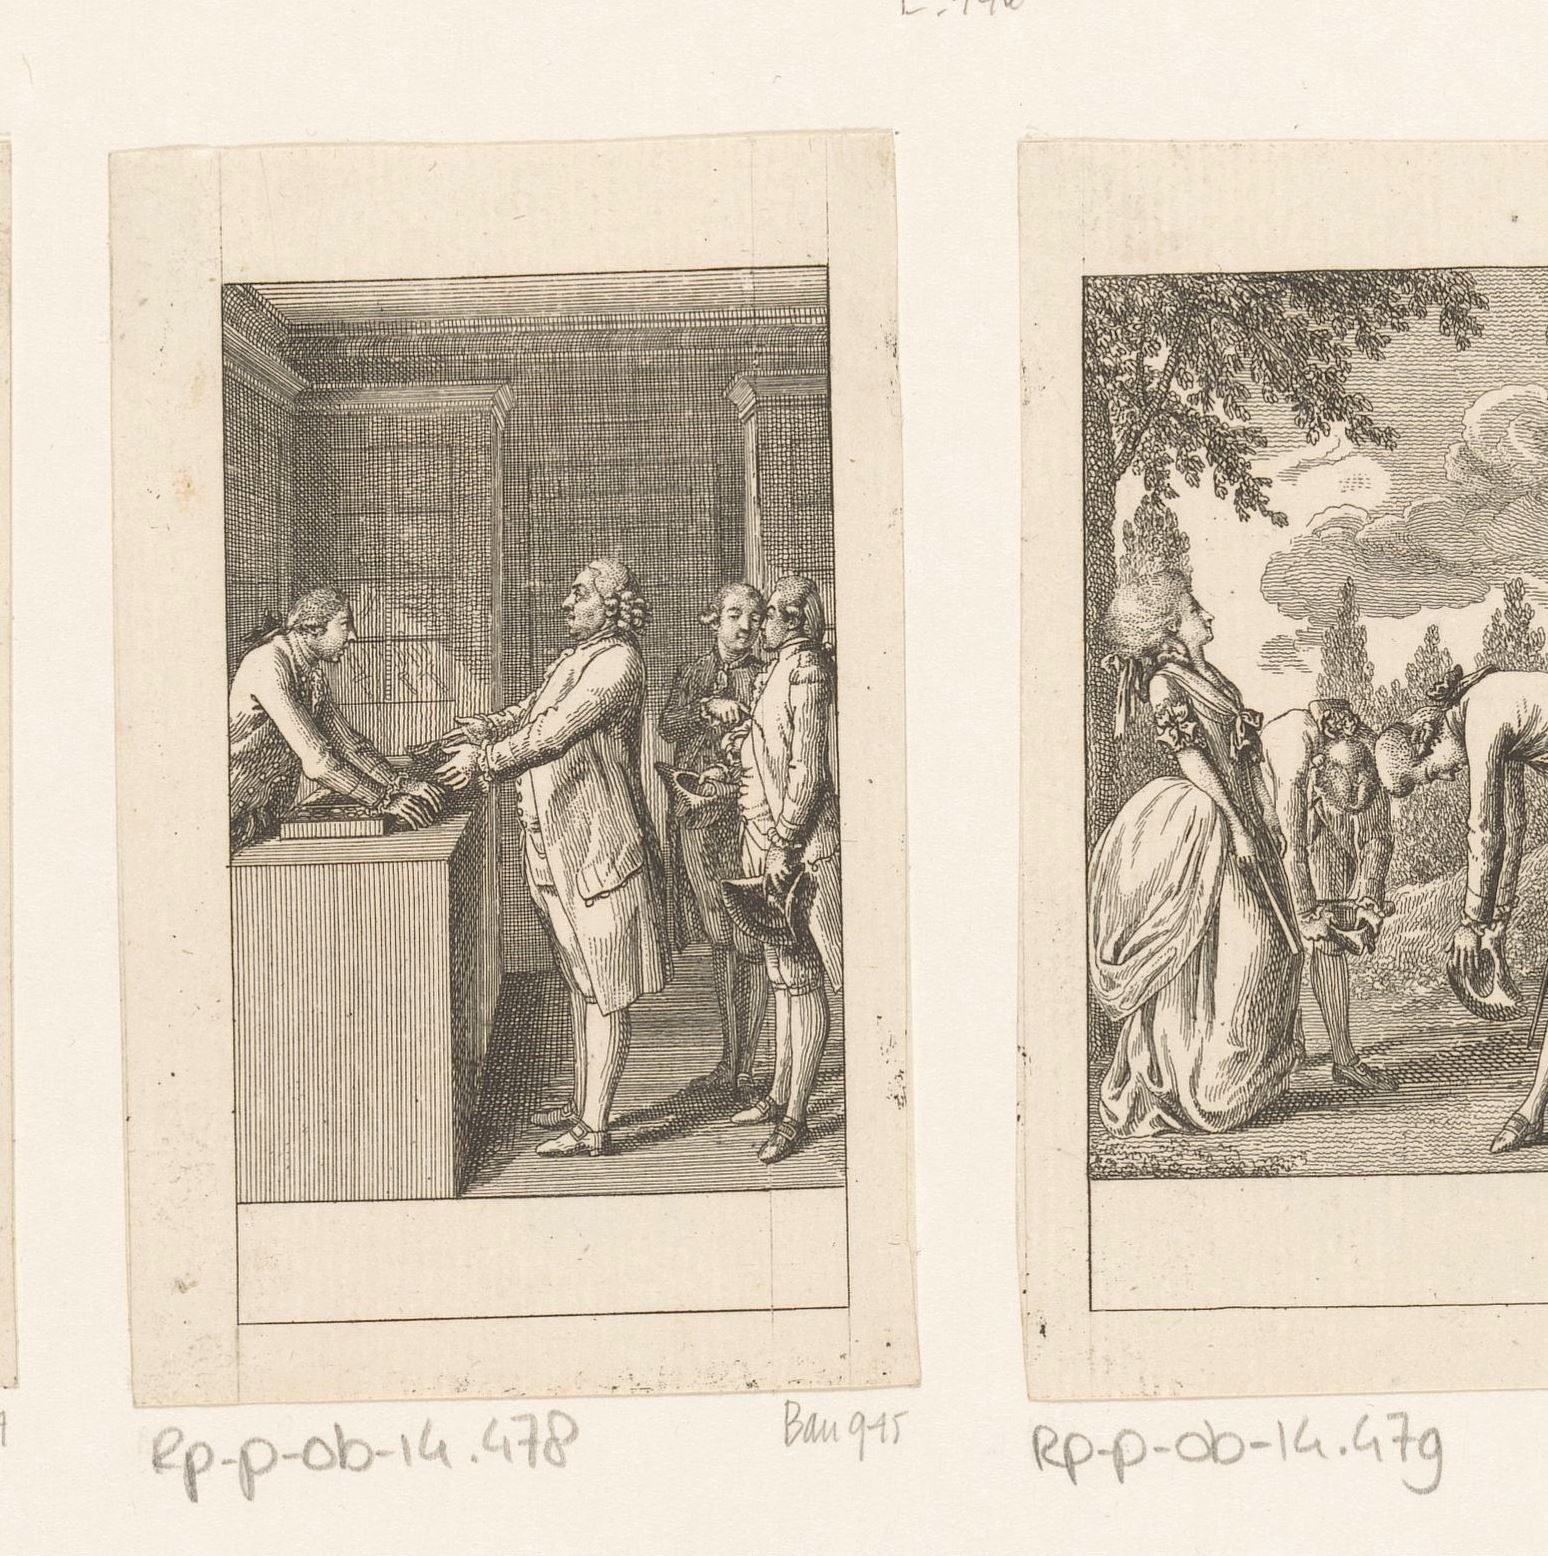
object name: print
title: Financiële dwaasheid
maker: daniel nikolaus chodowiecki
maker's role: draughtsman, print maker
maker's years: 1726-1801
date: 1782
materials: paper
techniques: etching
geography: berlin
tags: fool, simpleton, numskull, credit, banker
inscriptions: collector's mark: Lugt 2228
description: Vervaardigd voor Sancta Clara's 'Centifolium Stultorum'. Latere staat gebruikt voor: Goettinger Taschen Calender vom Jahr 1783. bey Joh. Chr. Dietrich. Göttingen: Georg Christoph Lichtenberg, 1782.